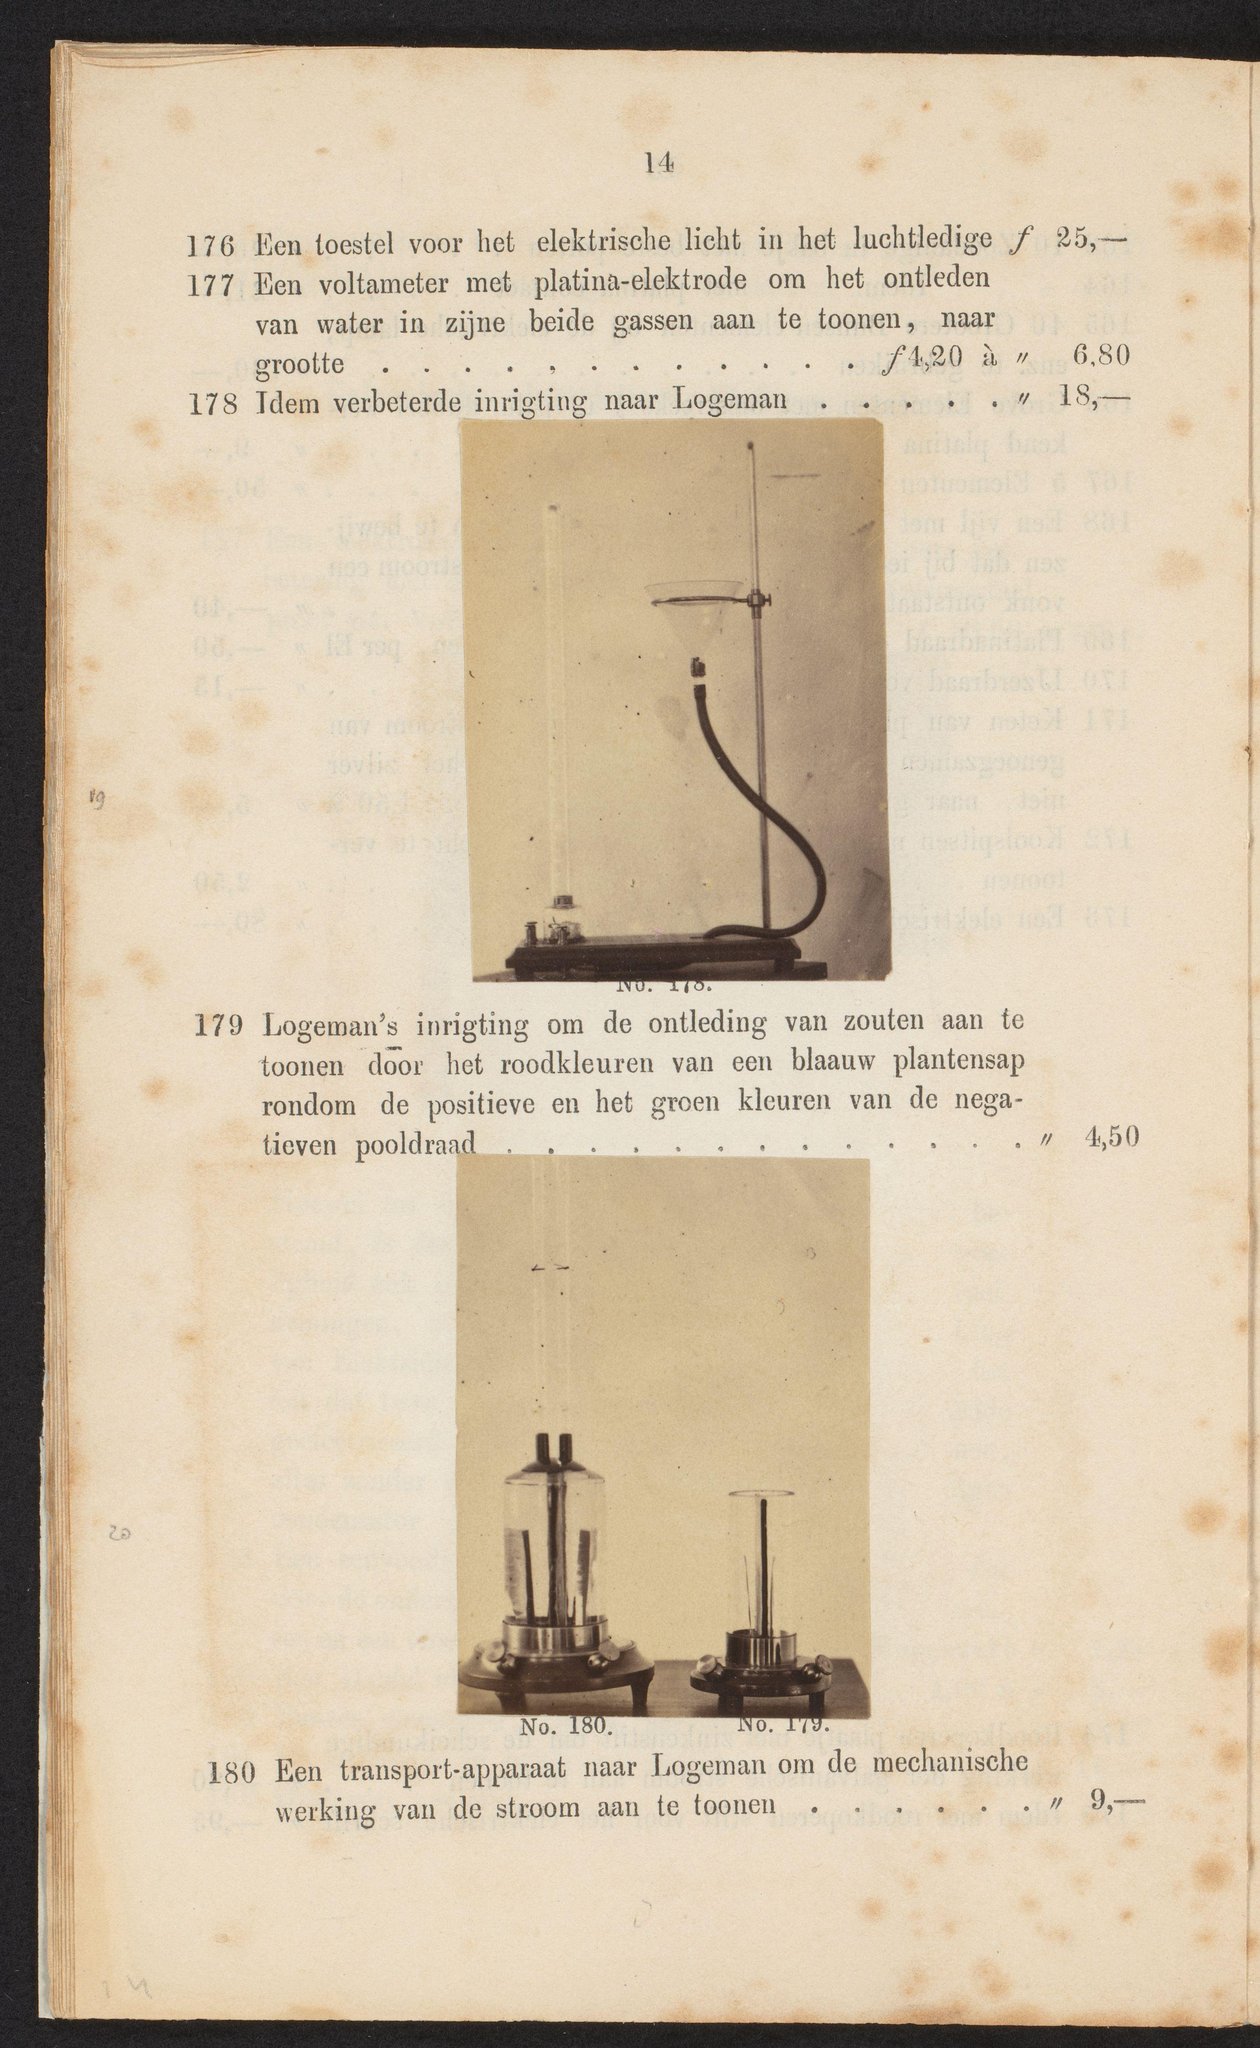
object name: photograph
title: Natuurkundige instrumenten naar Logeman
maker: fredrich wilhelm funckler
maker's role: instrument maker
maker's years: 1836-1886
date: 1857-1867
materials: paper, photographic support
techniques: albumen print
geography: netherlands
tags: physics (+ tools, instruments; laboratory equipment ~ scientific research)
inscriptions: number: ‘No. 178., No. 179., No. 180.’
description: Boven een voltameter, onder een instrument voor de ontleding van zouten en een apparaat ter aantoning van de mechanische werking van stroom.